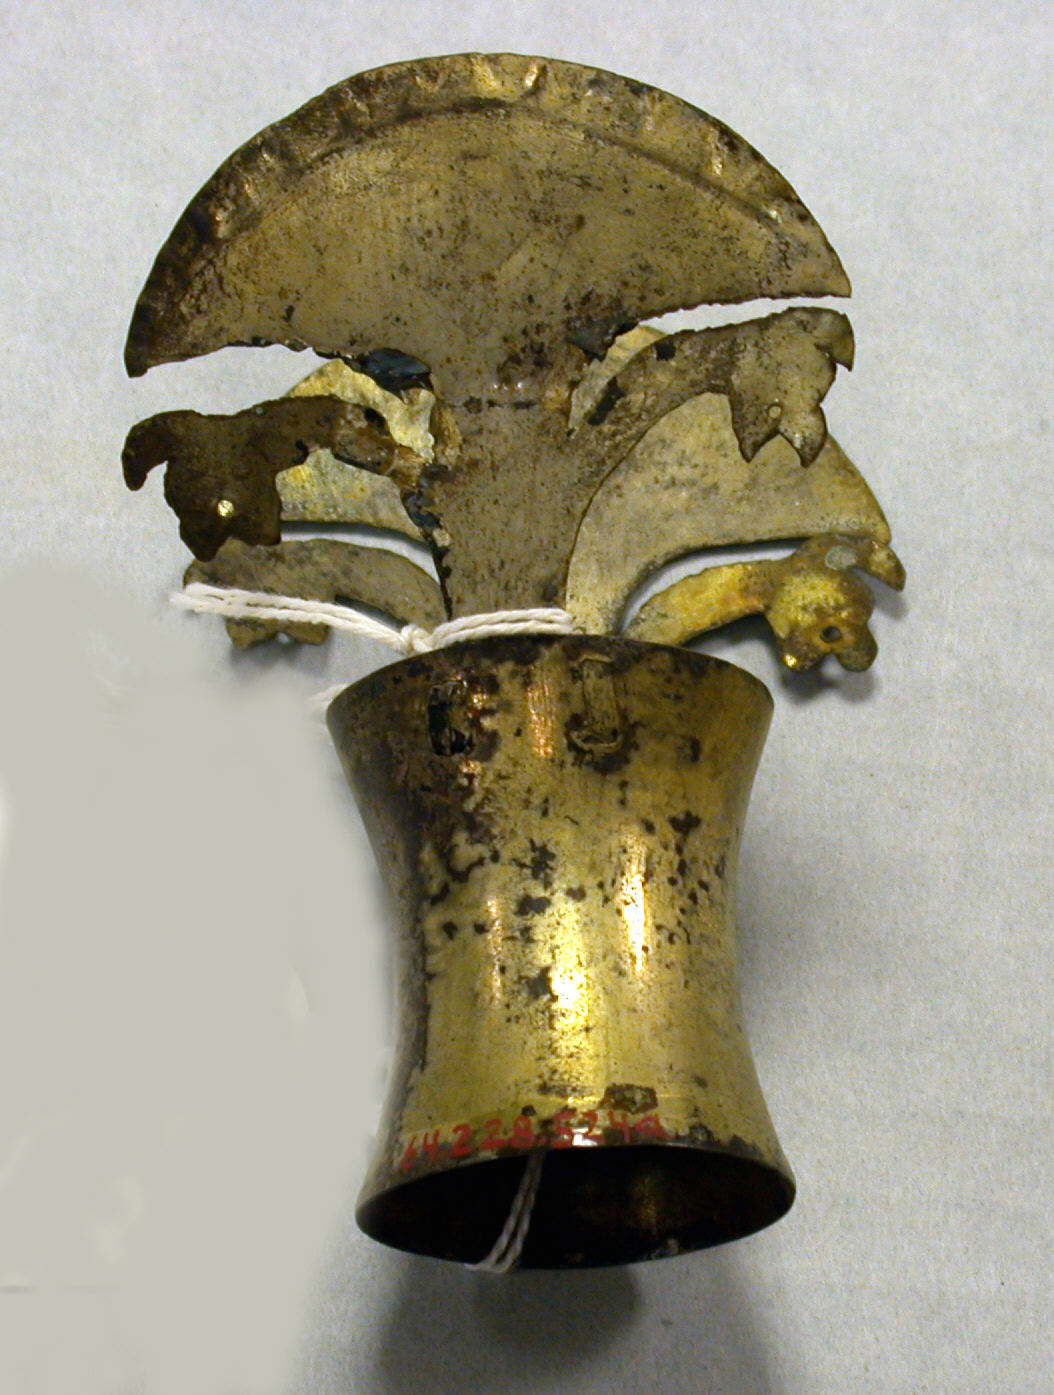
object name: crown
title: Hammered Silver Miniature Crown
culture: peruvian, north or central coast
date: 1001-1566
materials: gilt, silver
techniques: hammering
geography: peru